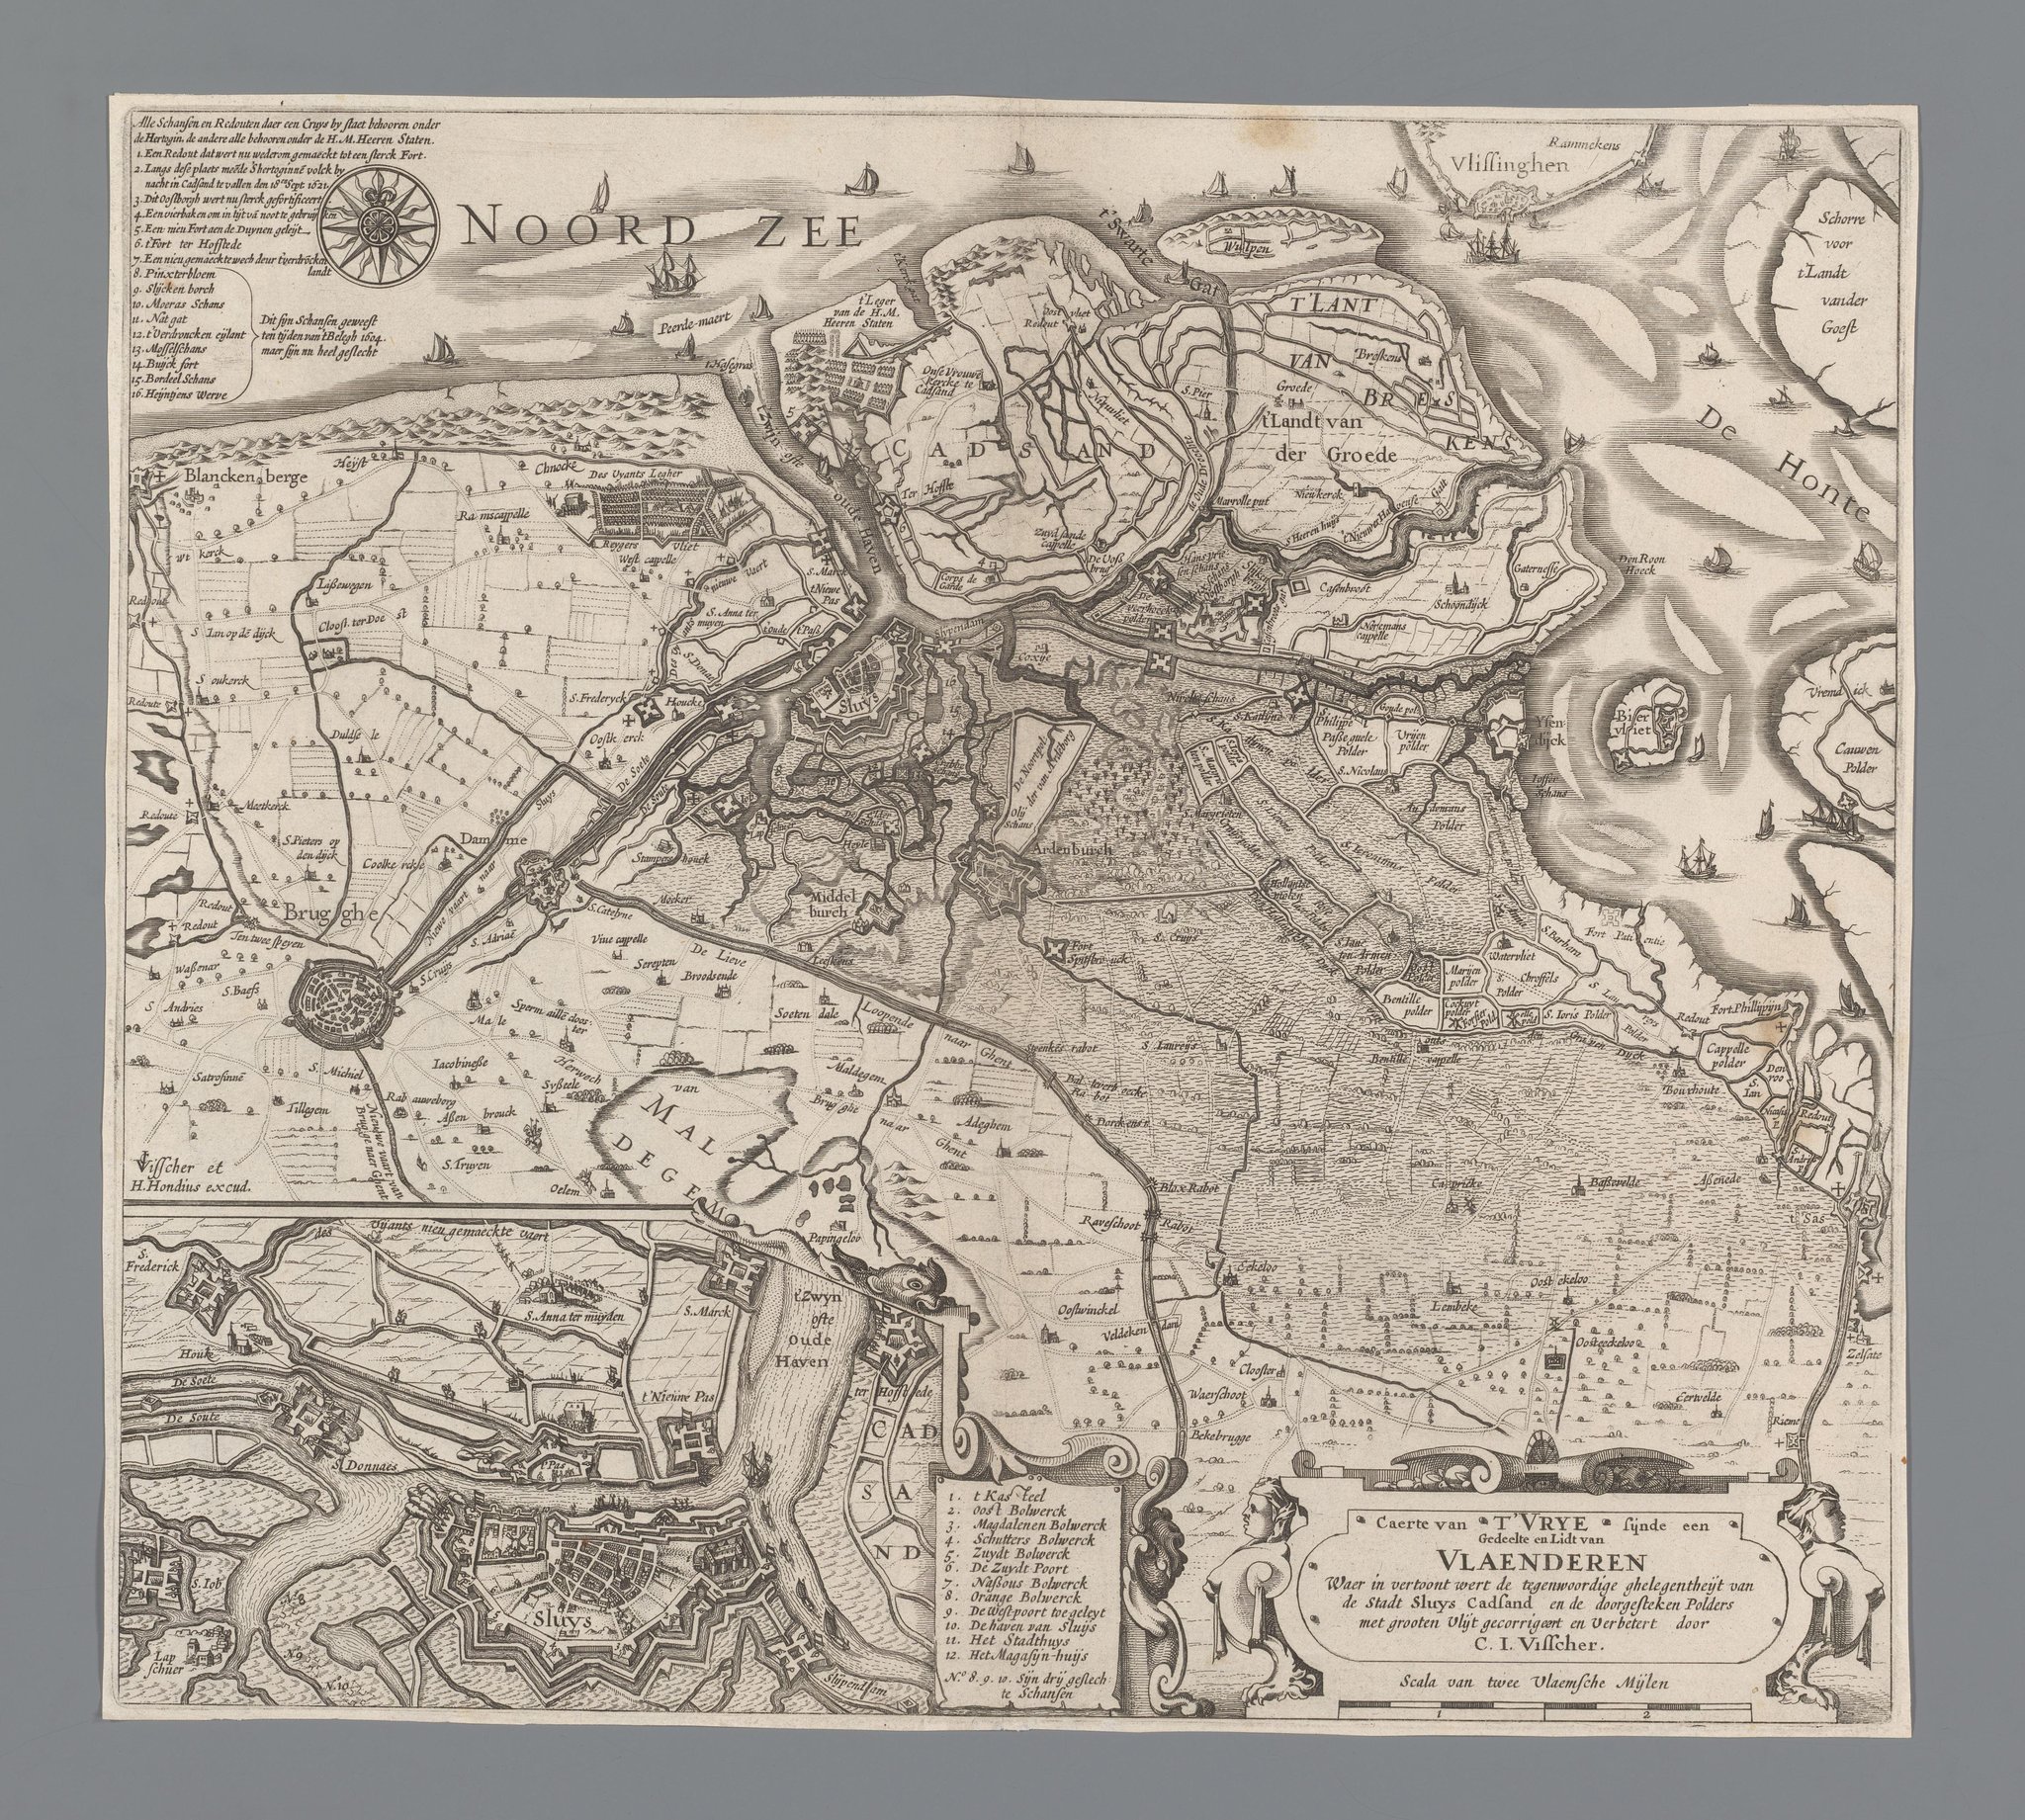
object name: print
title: Caerte van t'Vrye sijnde een gedeelte en Lidt van Vlaenderen (...)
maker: claes jansz. visscher (ii)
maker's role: draughtsman, print maker, publisher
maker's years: 1586-1652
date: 1634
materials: paper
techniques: engraving, etching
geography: amsterdam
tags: maps of separate countries or regions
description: Kaart van Zeeuws-Vlaanderen met linksonder een inzet van Sluis en de vestingen in de omgeving van Sluis. Rechtsonder een cartouche met titel en schaalstok: Scala van twee Vlaemsche mijlen. Linksboven een kompasroos en de legenda van de kaart 1-16. Midden onder de legenda behorend bij de inzet 1-12.